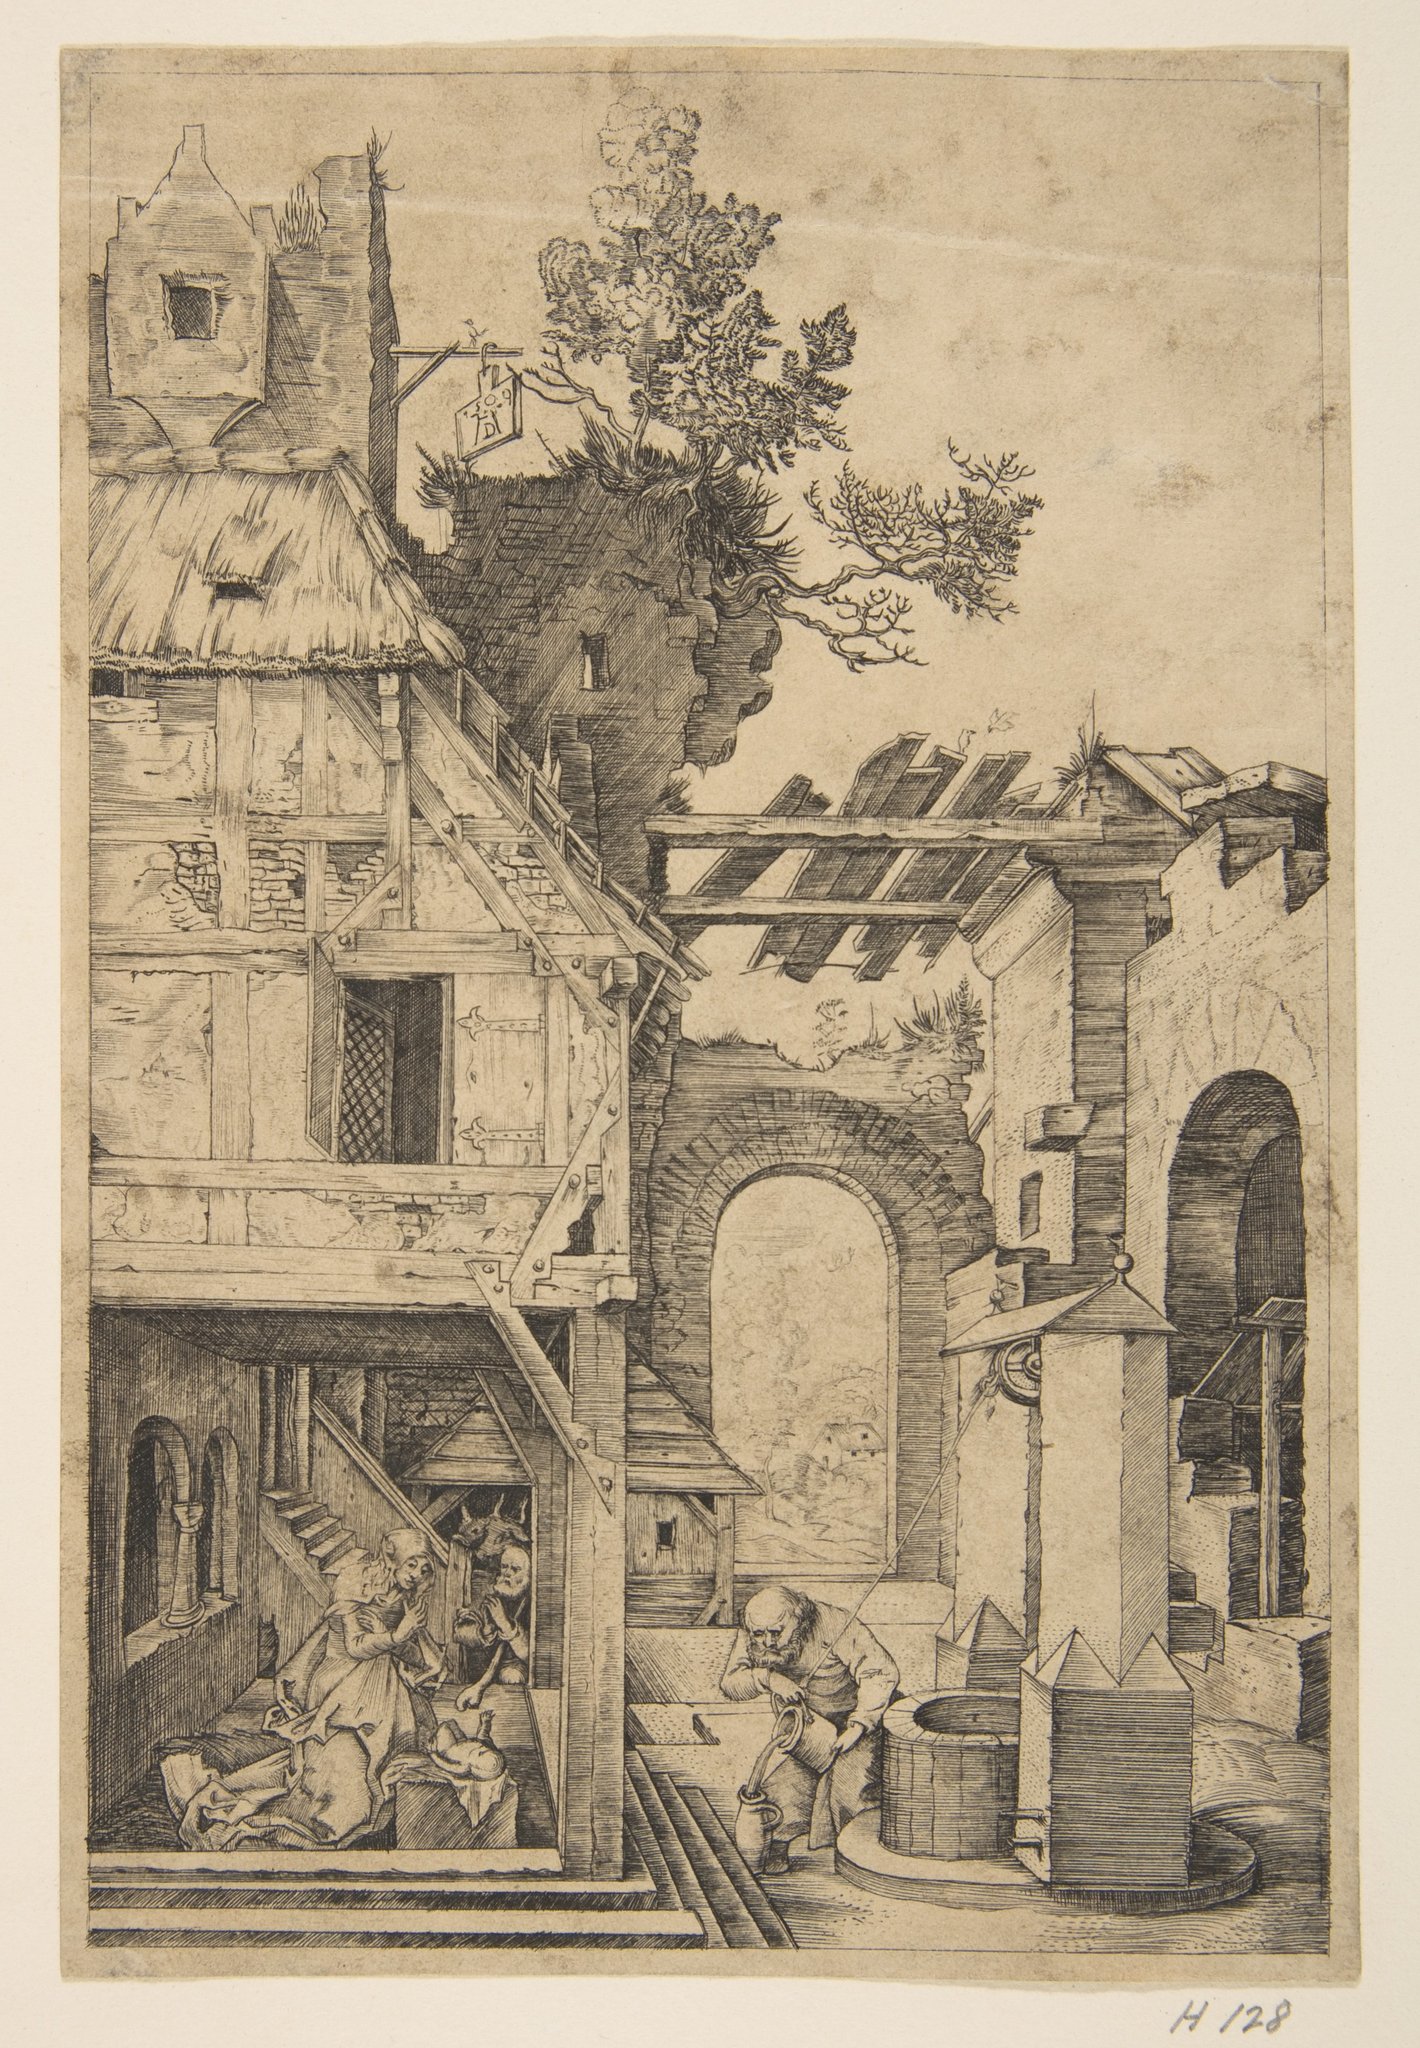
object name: print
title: The Nativity (copy)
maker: albrecht dürer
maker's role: artist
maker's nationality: german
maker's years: 1471-1528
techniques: engraving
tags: nativity